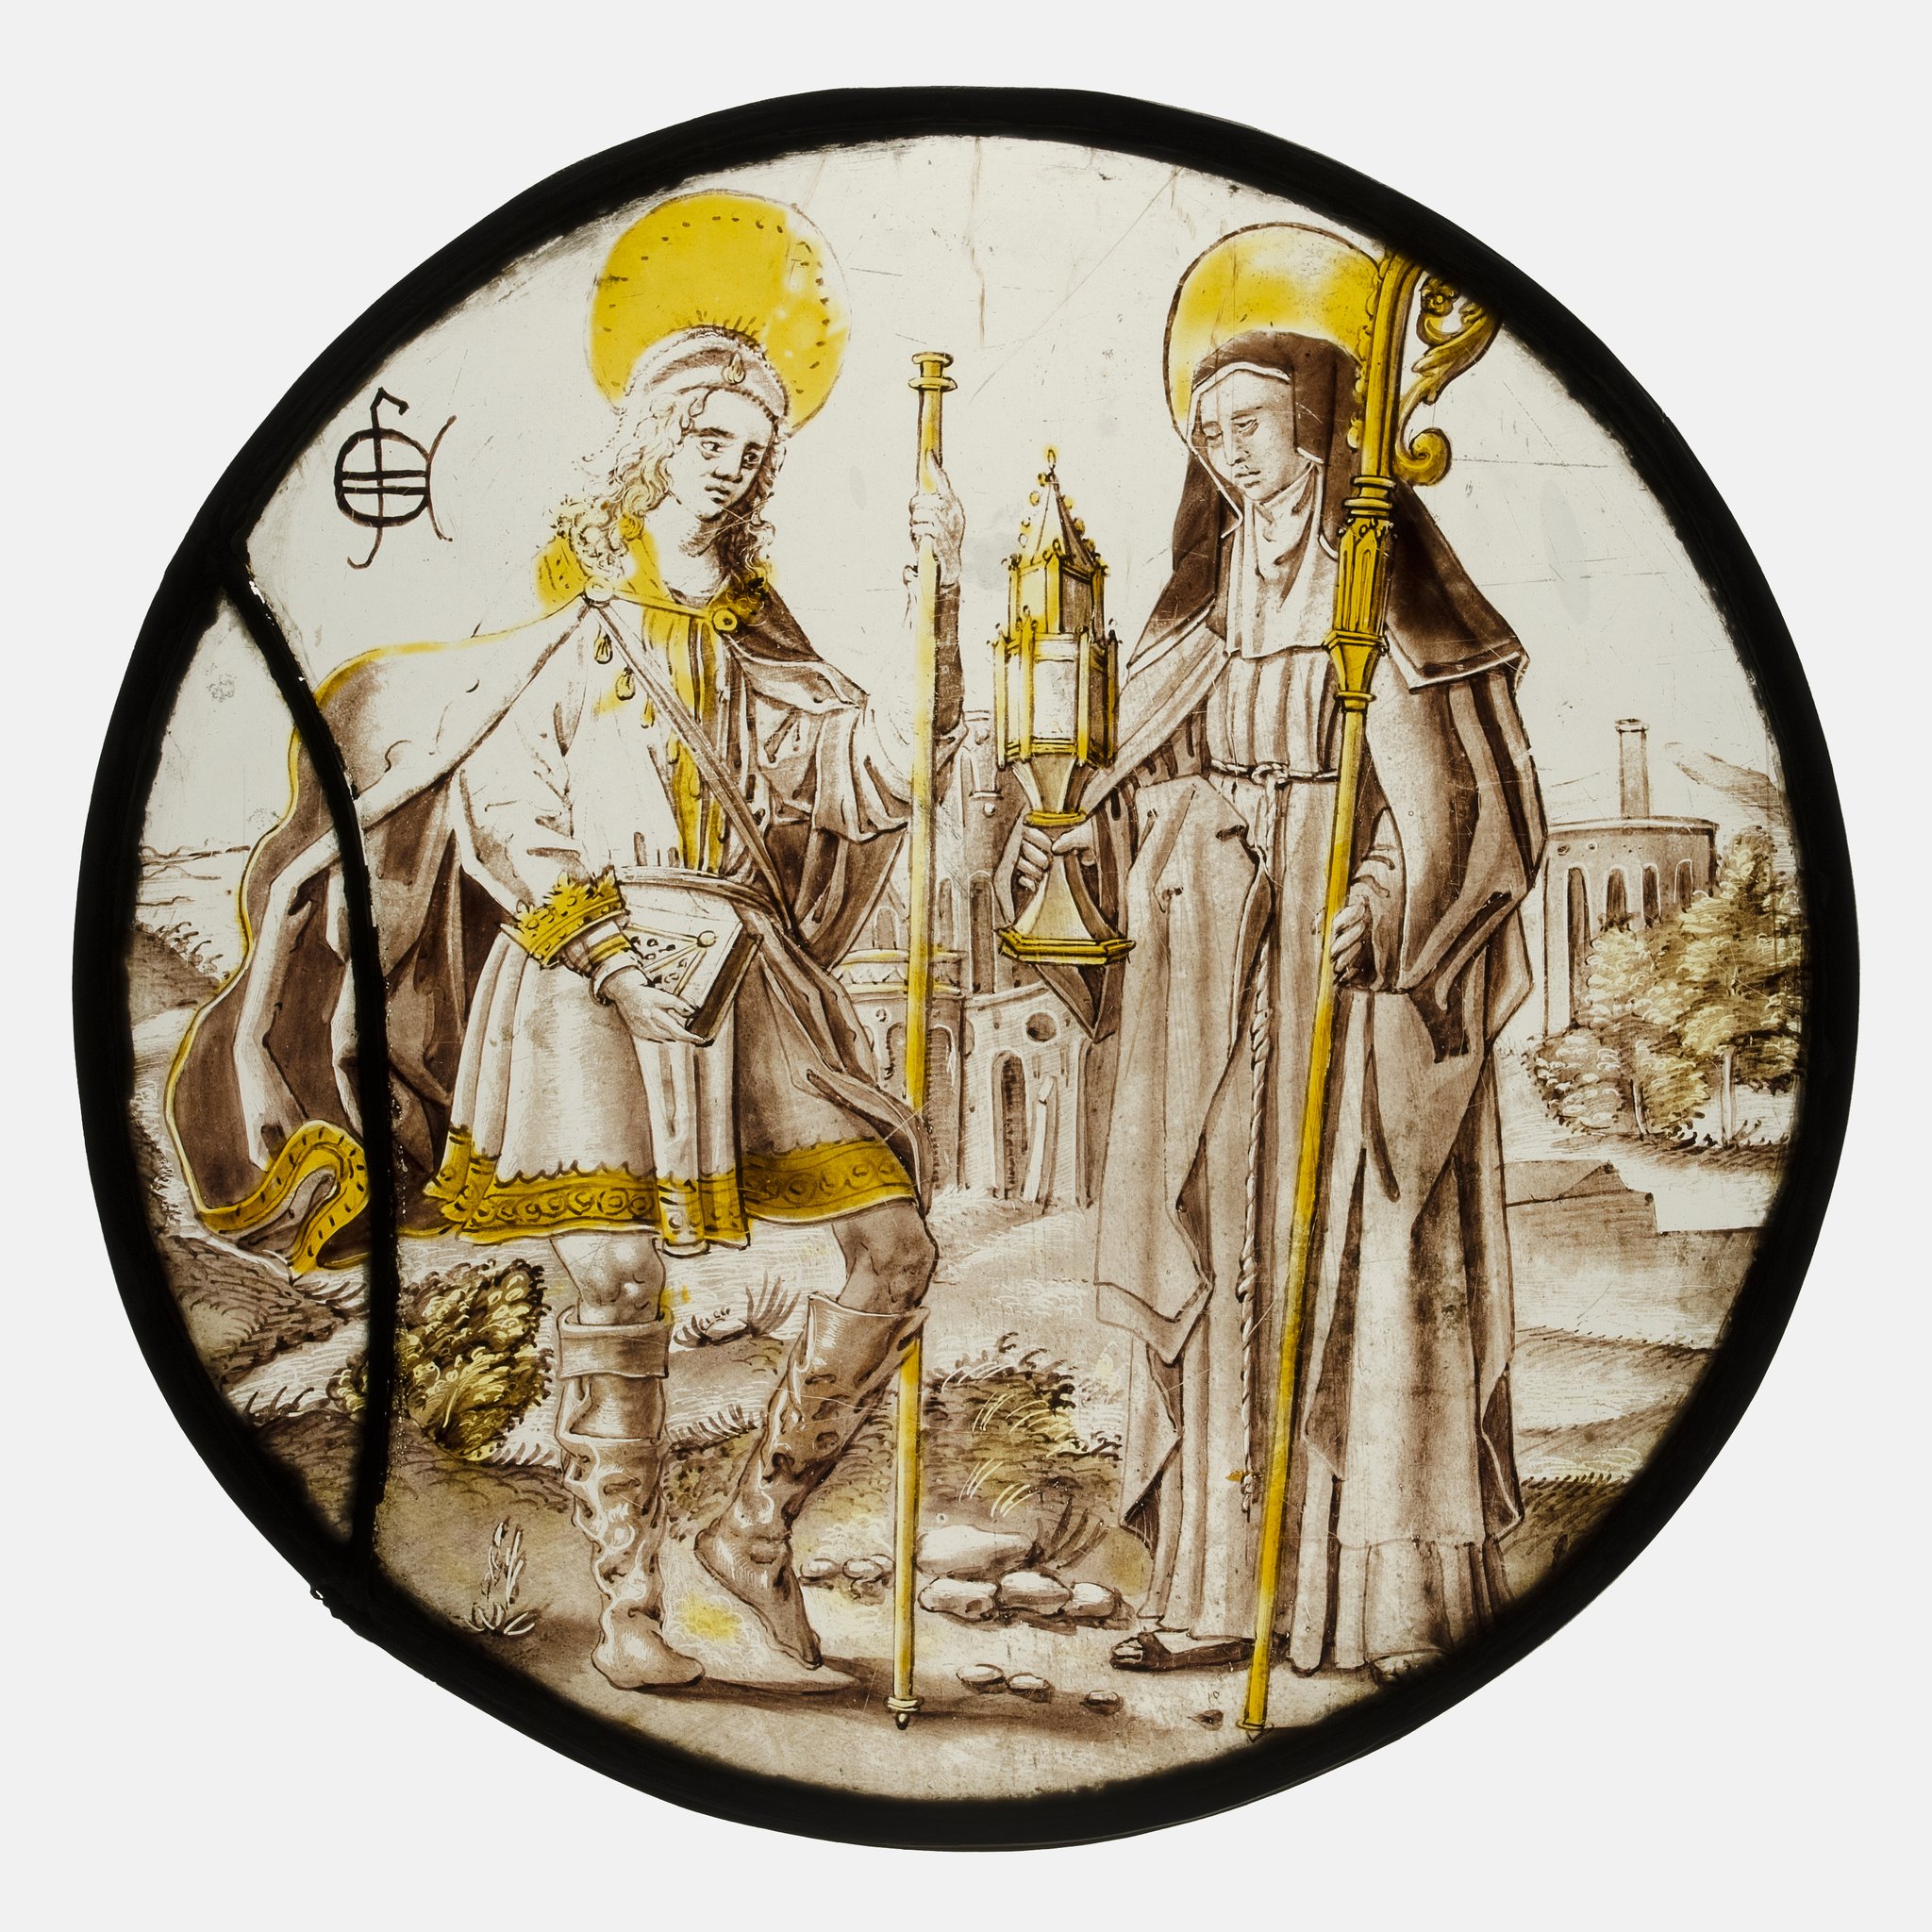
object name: roundel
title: Roundel with Saint Jodocus and St. Clare of Assisi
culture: south netherlandish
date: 1520-1530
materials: glass, paint, pigment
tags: men,women,saints